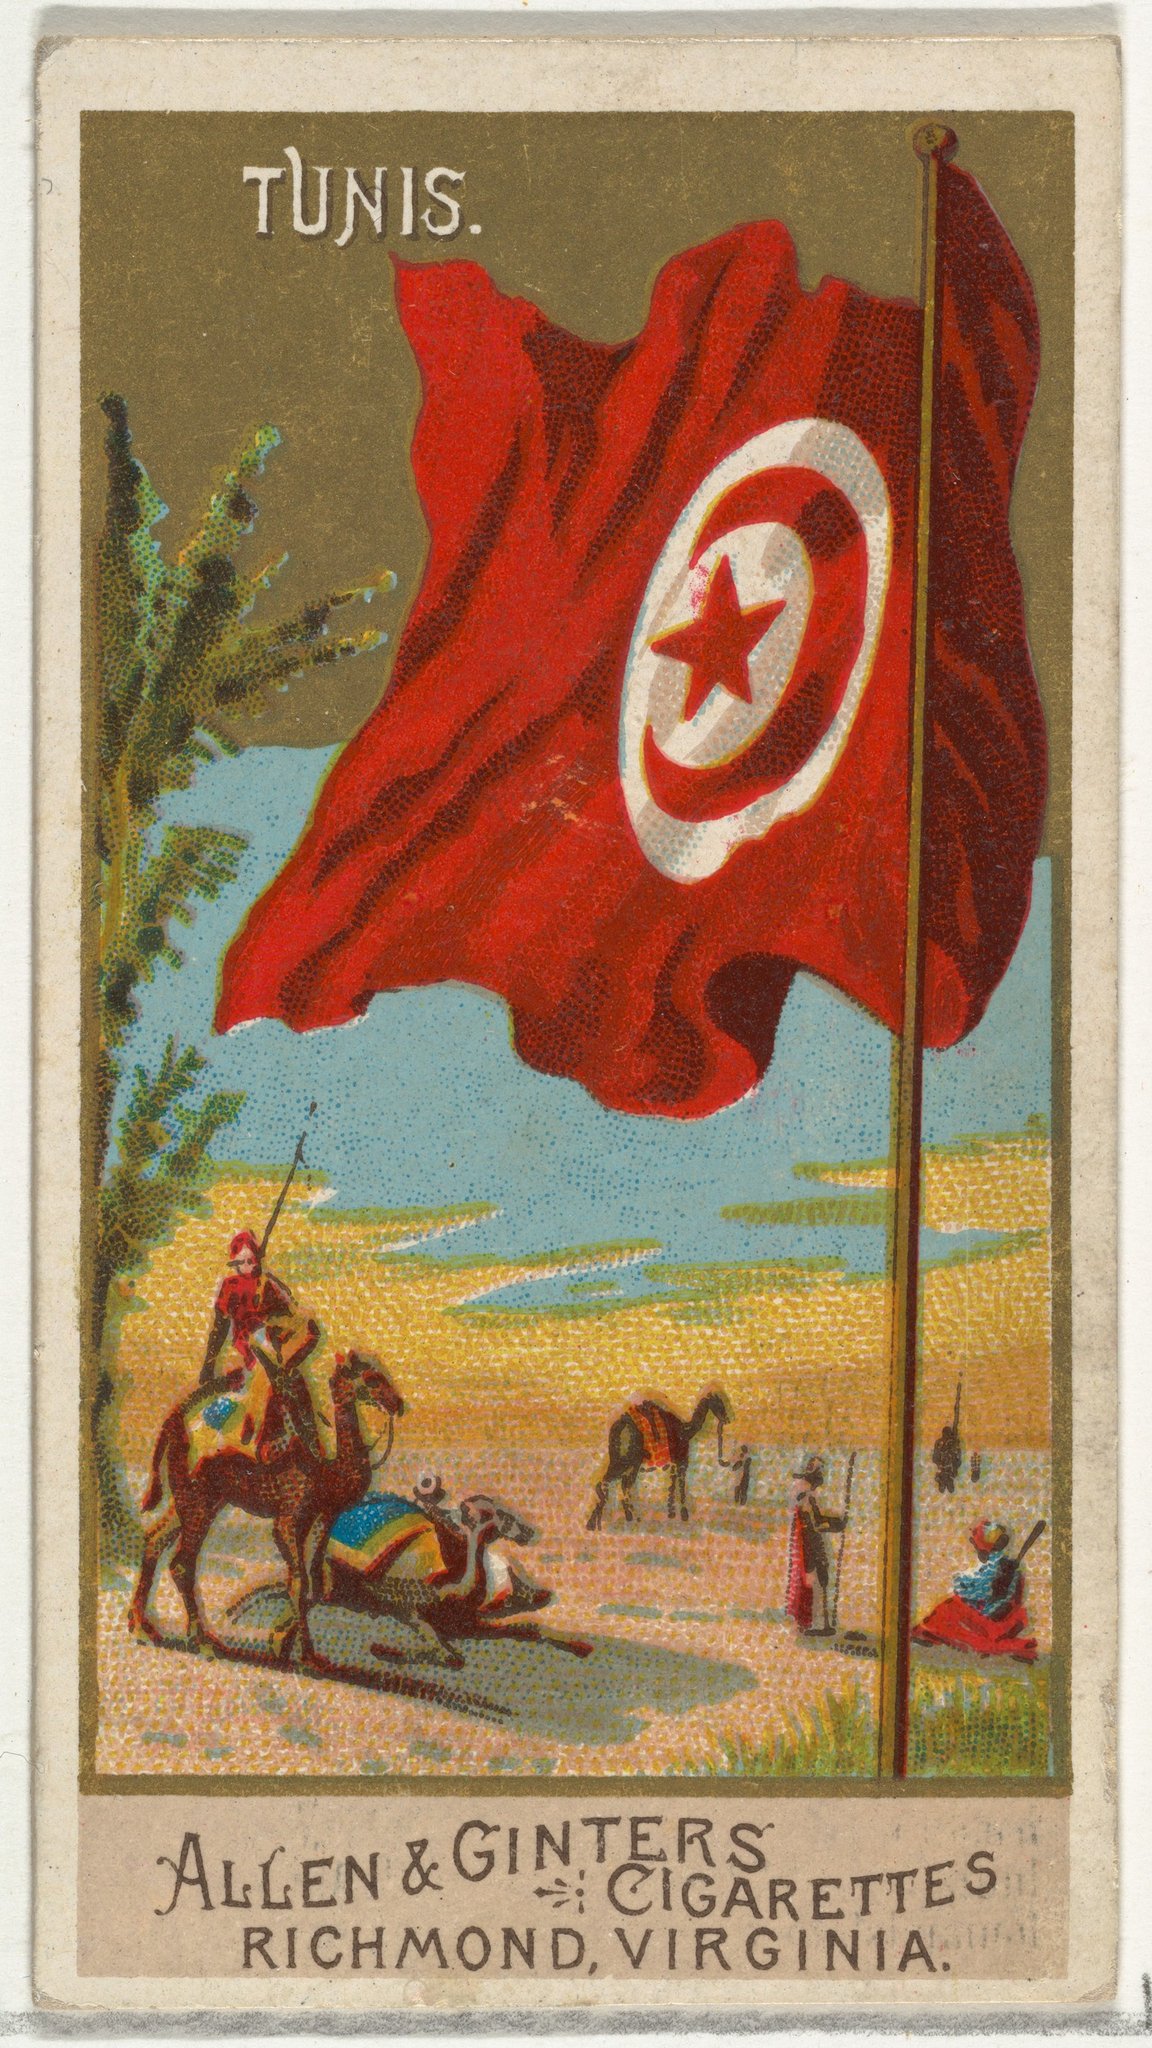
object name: print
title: Tunis, from Flags of All Nations, Series 2 (N10) for Allen & Ginter Cigarettes Brands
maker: allen & ginter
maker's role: publisher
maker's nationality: american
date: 1890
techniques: color lithograph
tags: flags